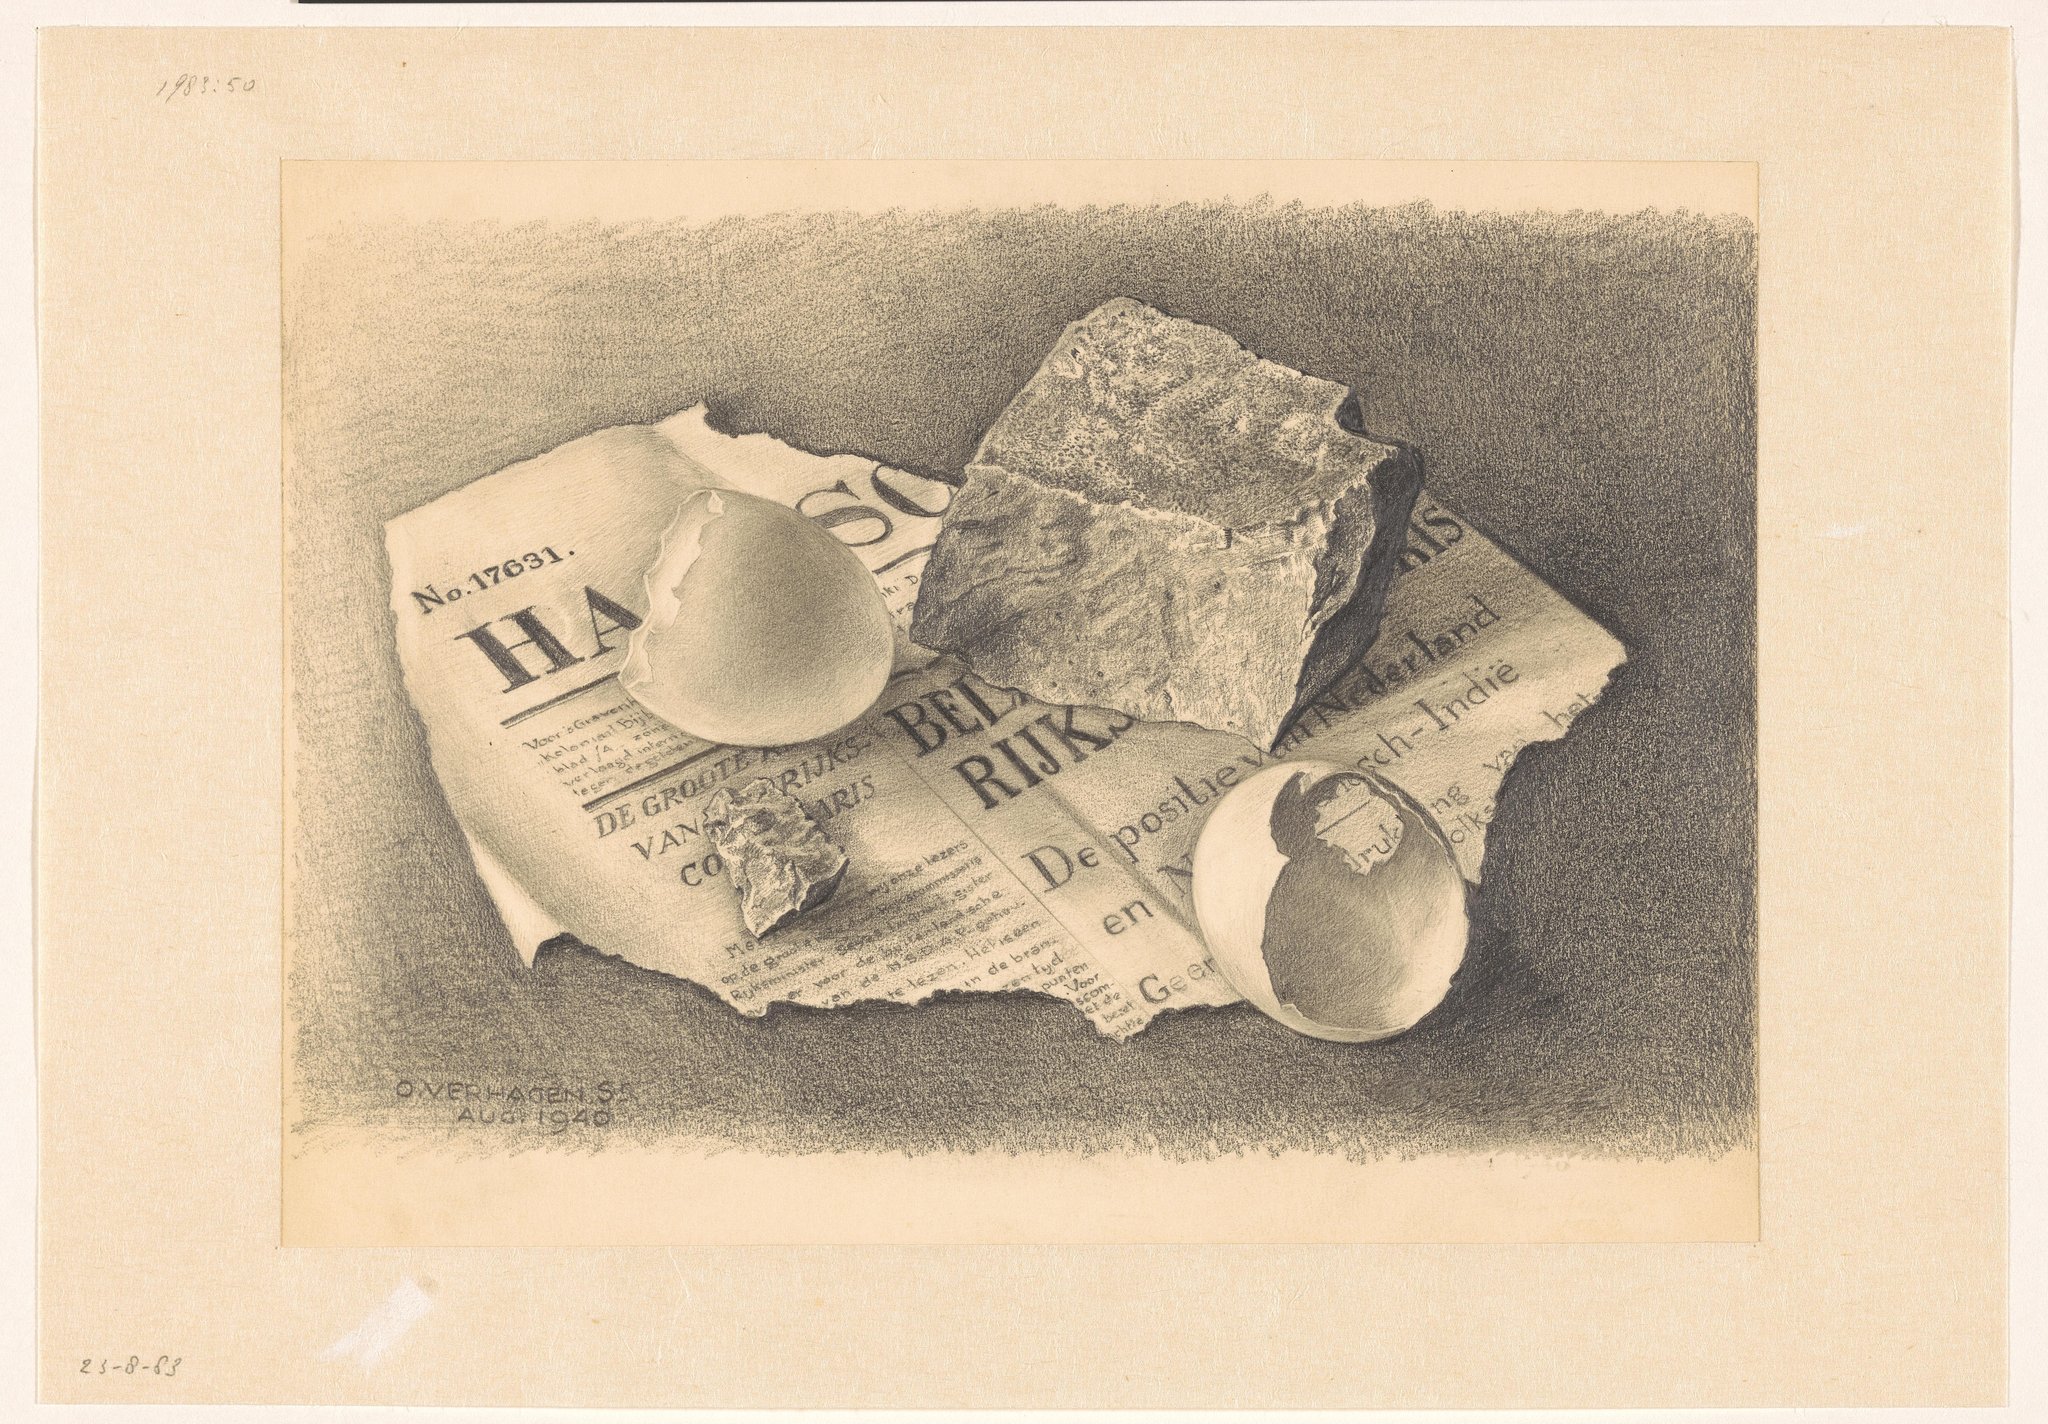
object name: drawing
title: Stilleven met stenen, eierschalen en een stuk krant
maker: otto verhagen (i)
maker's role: draughtsman, print maker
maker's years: 1885-1951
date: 1908-1940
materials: paper, pencil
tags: eggs, egg-dishes, still life of miscellaneous objects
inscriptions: date